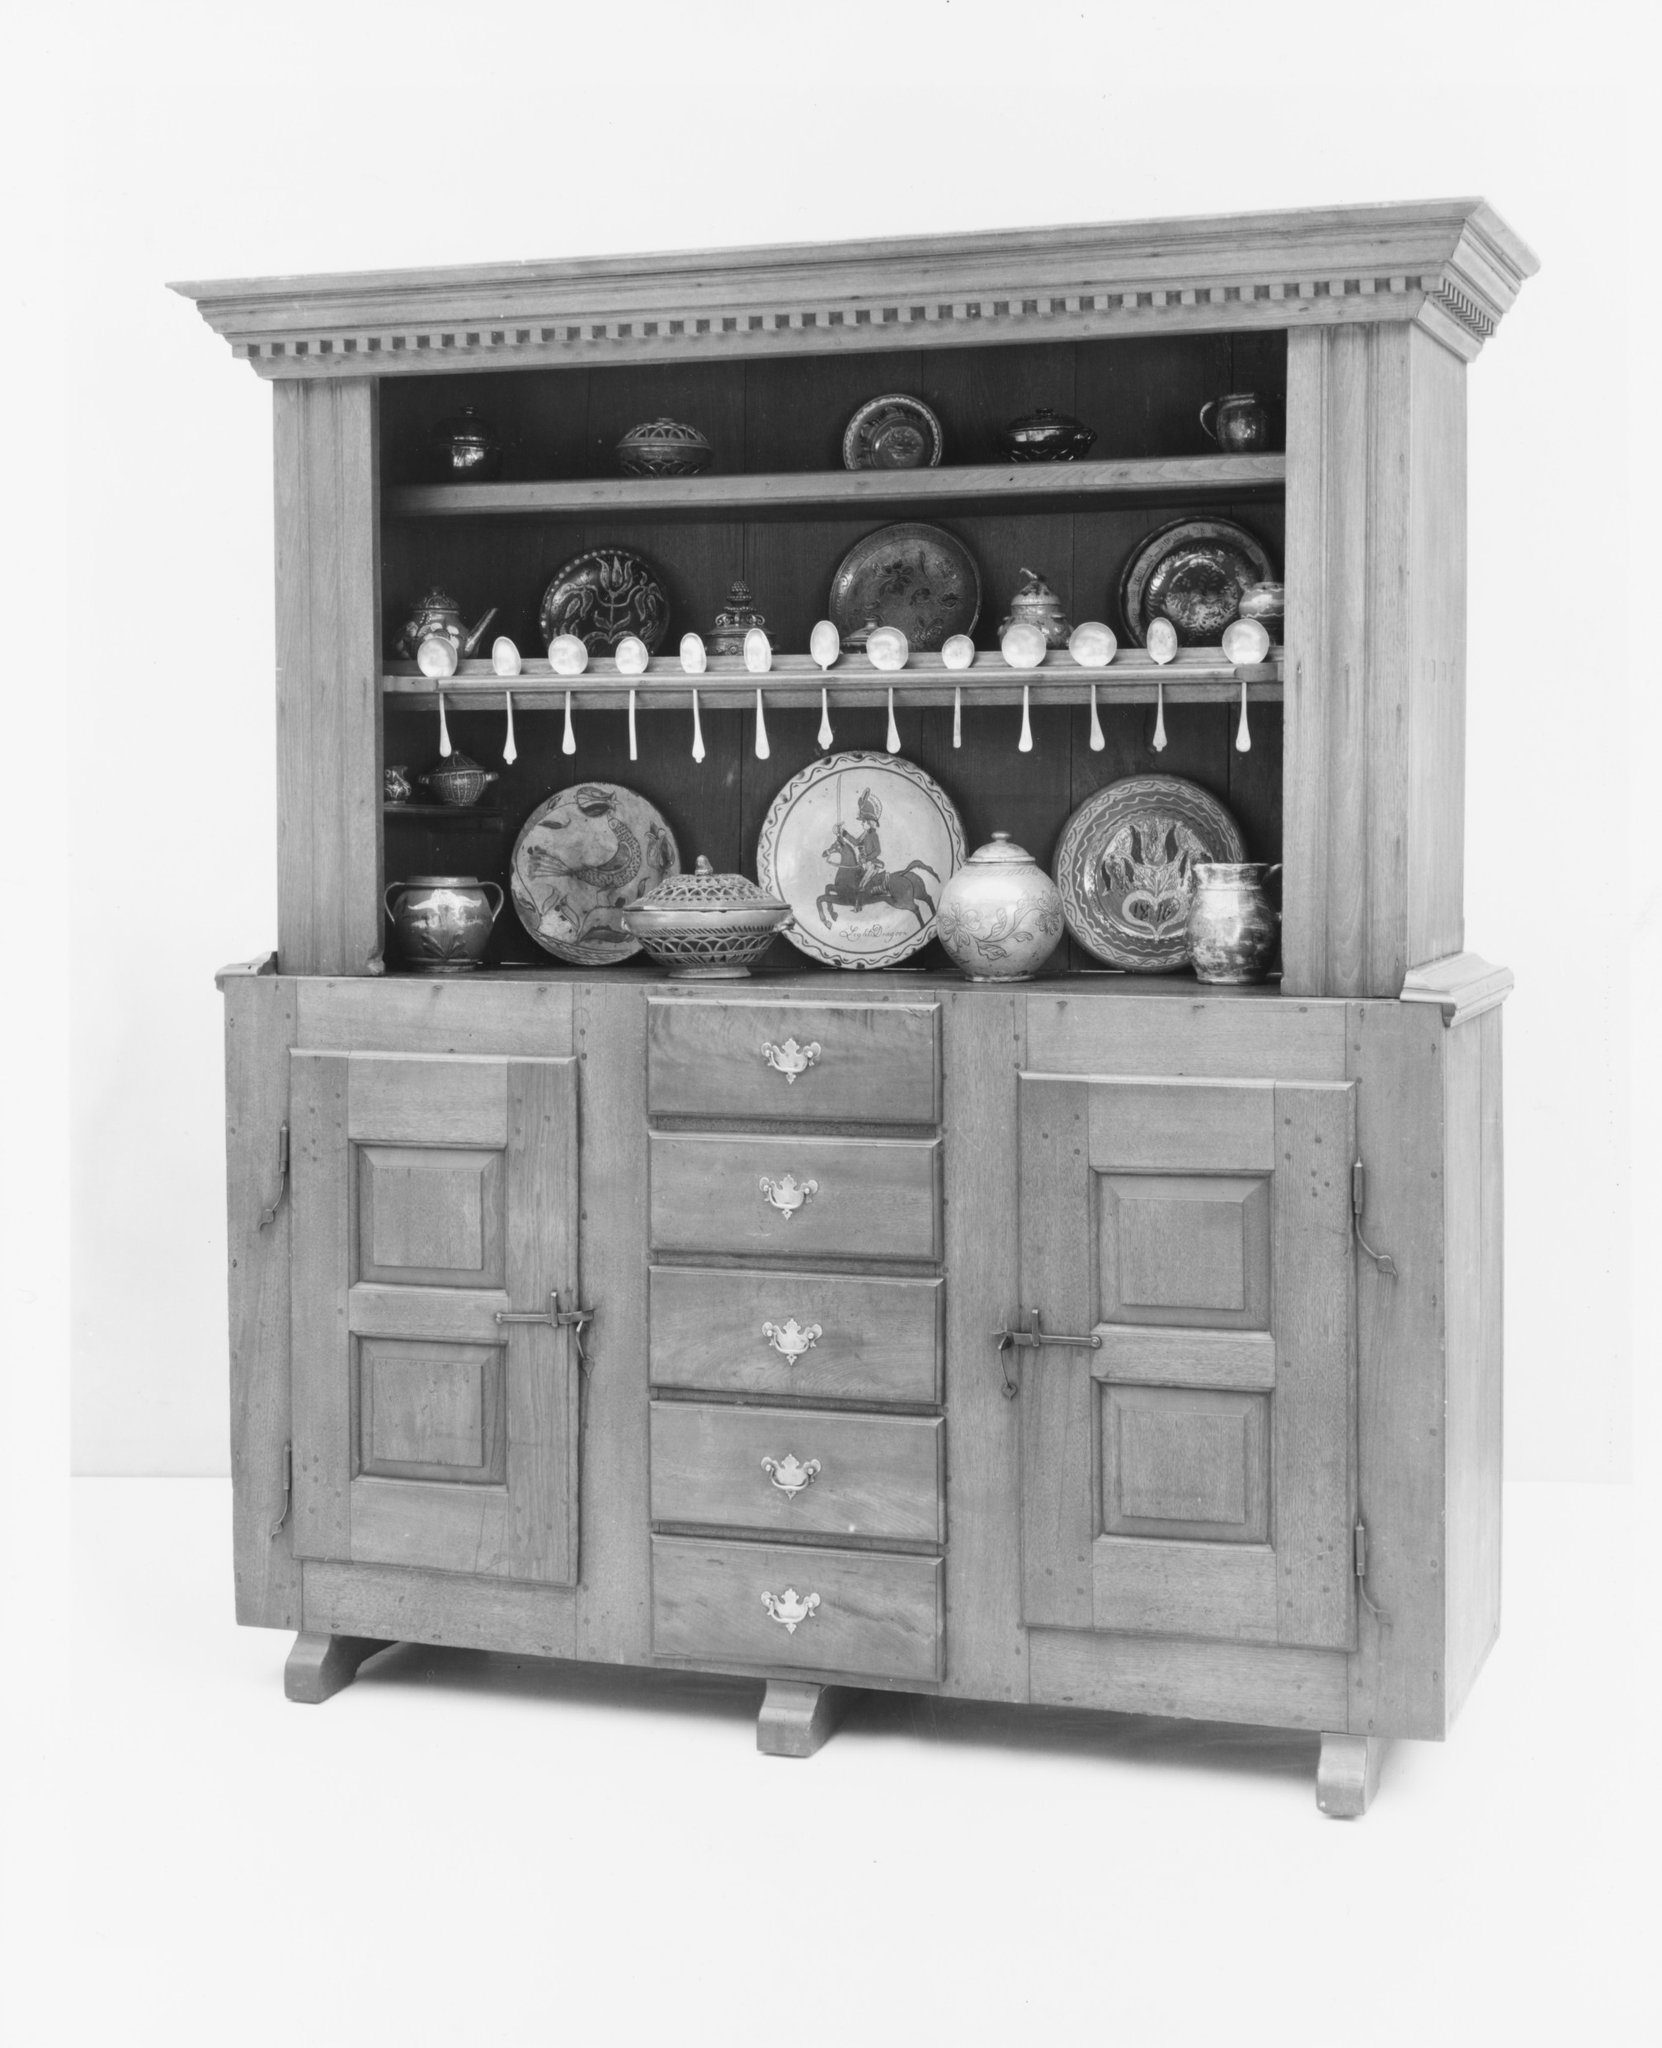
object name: dresser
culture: american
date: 1700-1800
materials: wood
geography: united states